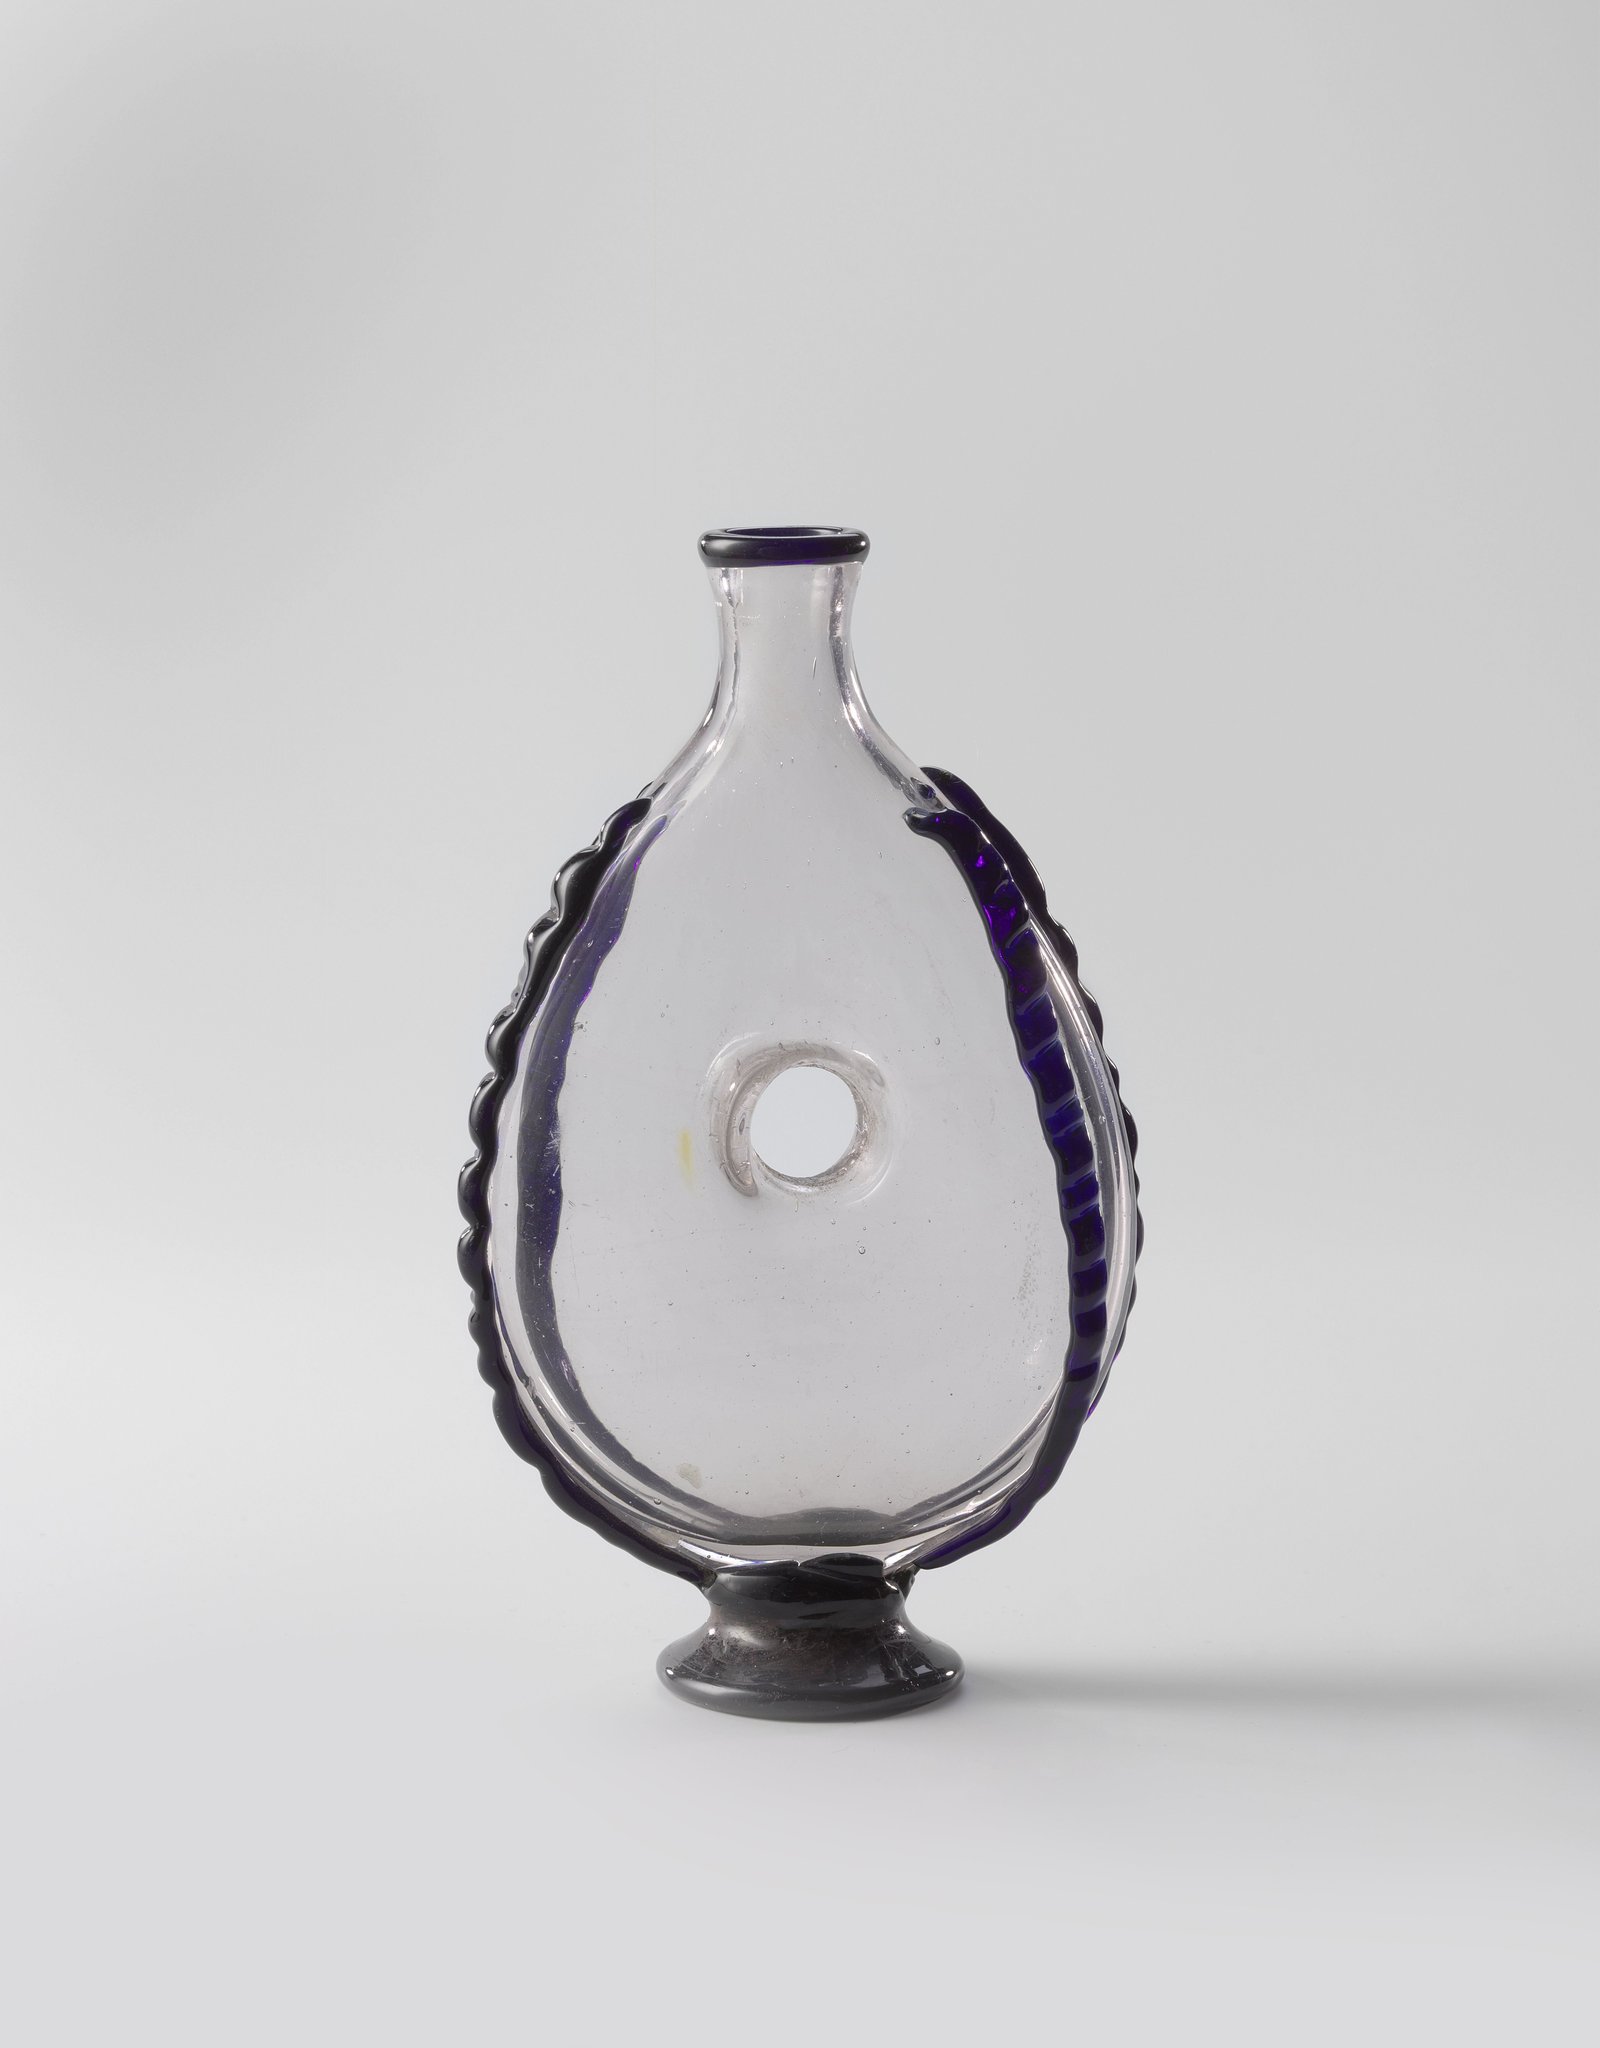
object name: flacon, flakon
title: Flacon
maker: Anonymous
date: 1700-1800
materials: glass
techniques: façon de venise, glassblowing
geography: western europe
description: Conische voet van paarsblauw glas. Zijdelings afgeplat, ringvormig lichaam, overgaand in een korte, enigszins uitgebogen hals met een paarsblauw randje. Op de smalle kanten twee geribde paarsblauwe draden.